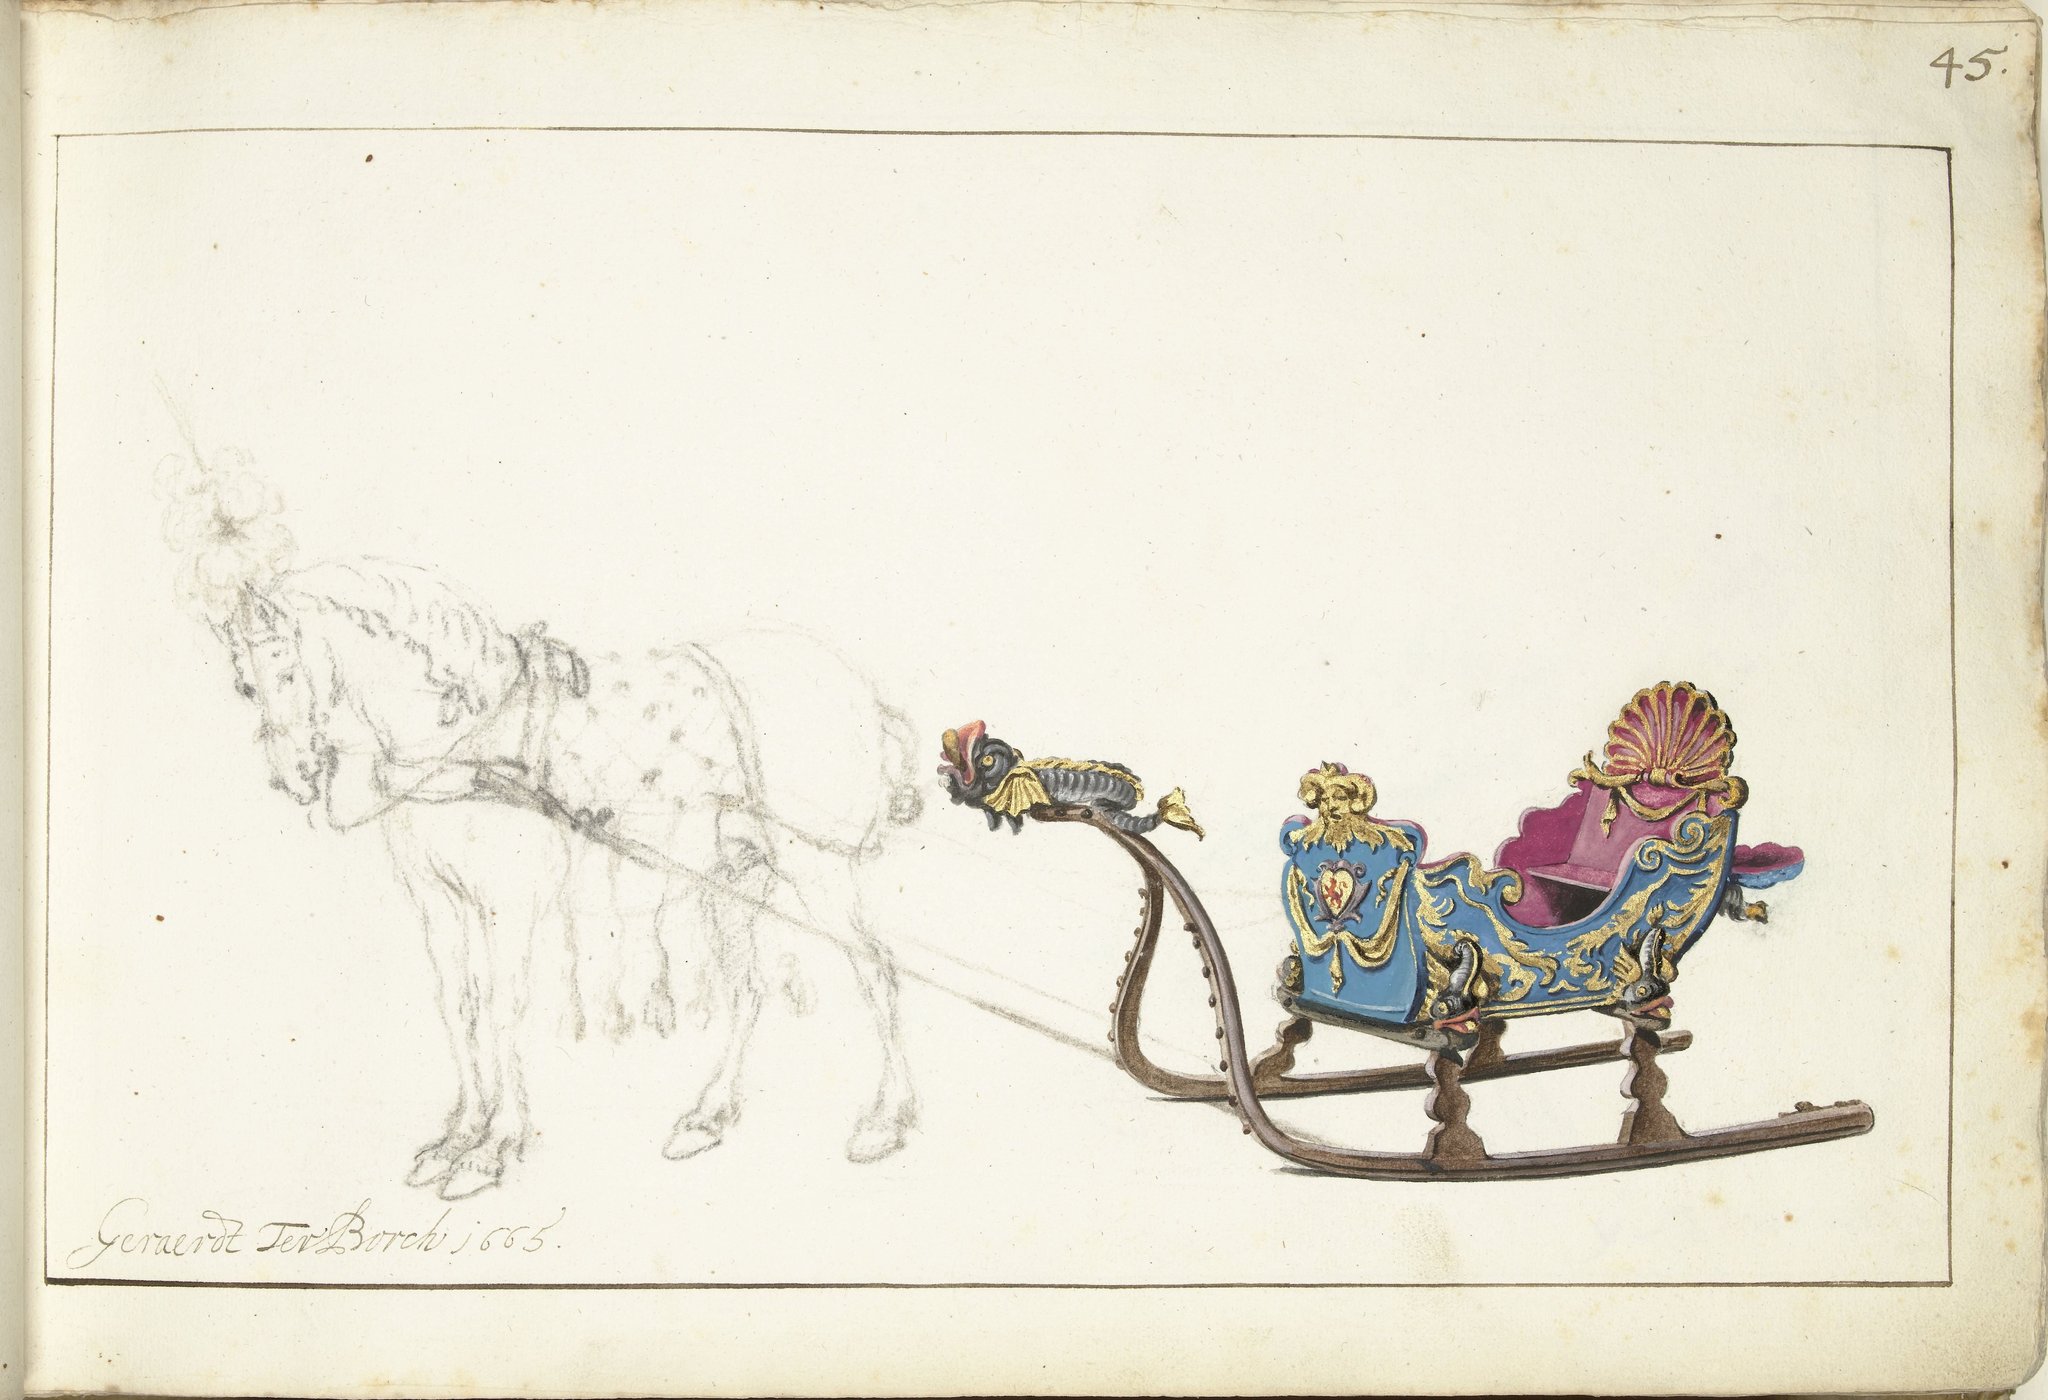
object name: watercolor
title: Paard en slede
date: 1665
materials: chalk, paper, watercolor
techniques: brush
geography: deventer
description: Paard en slede met voorop het familiewapen van de Ter Borchs.